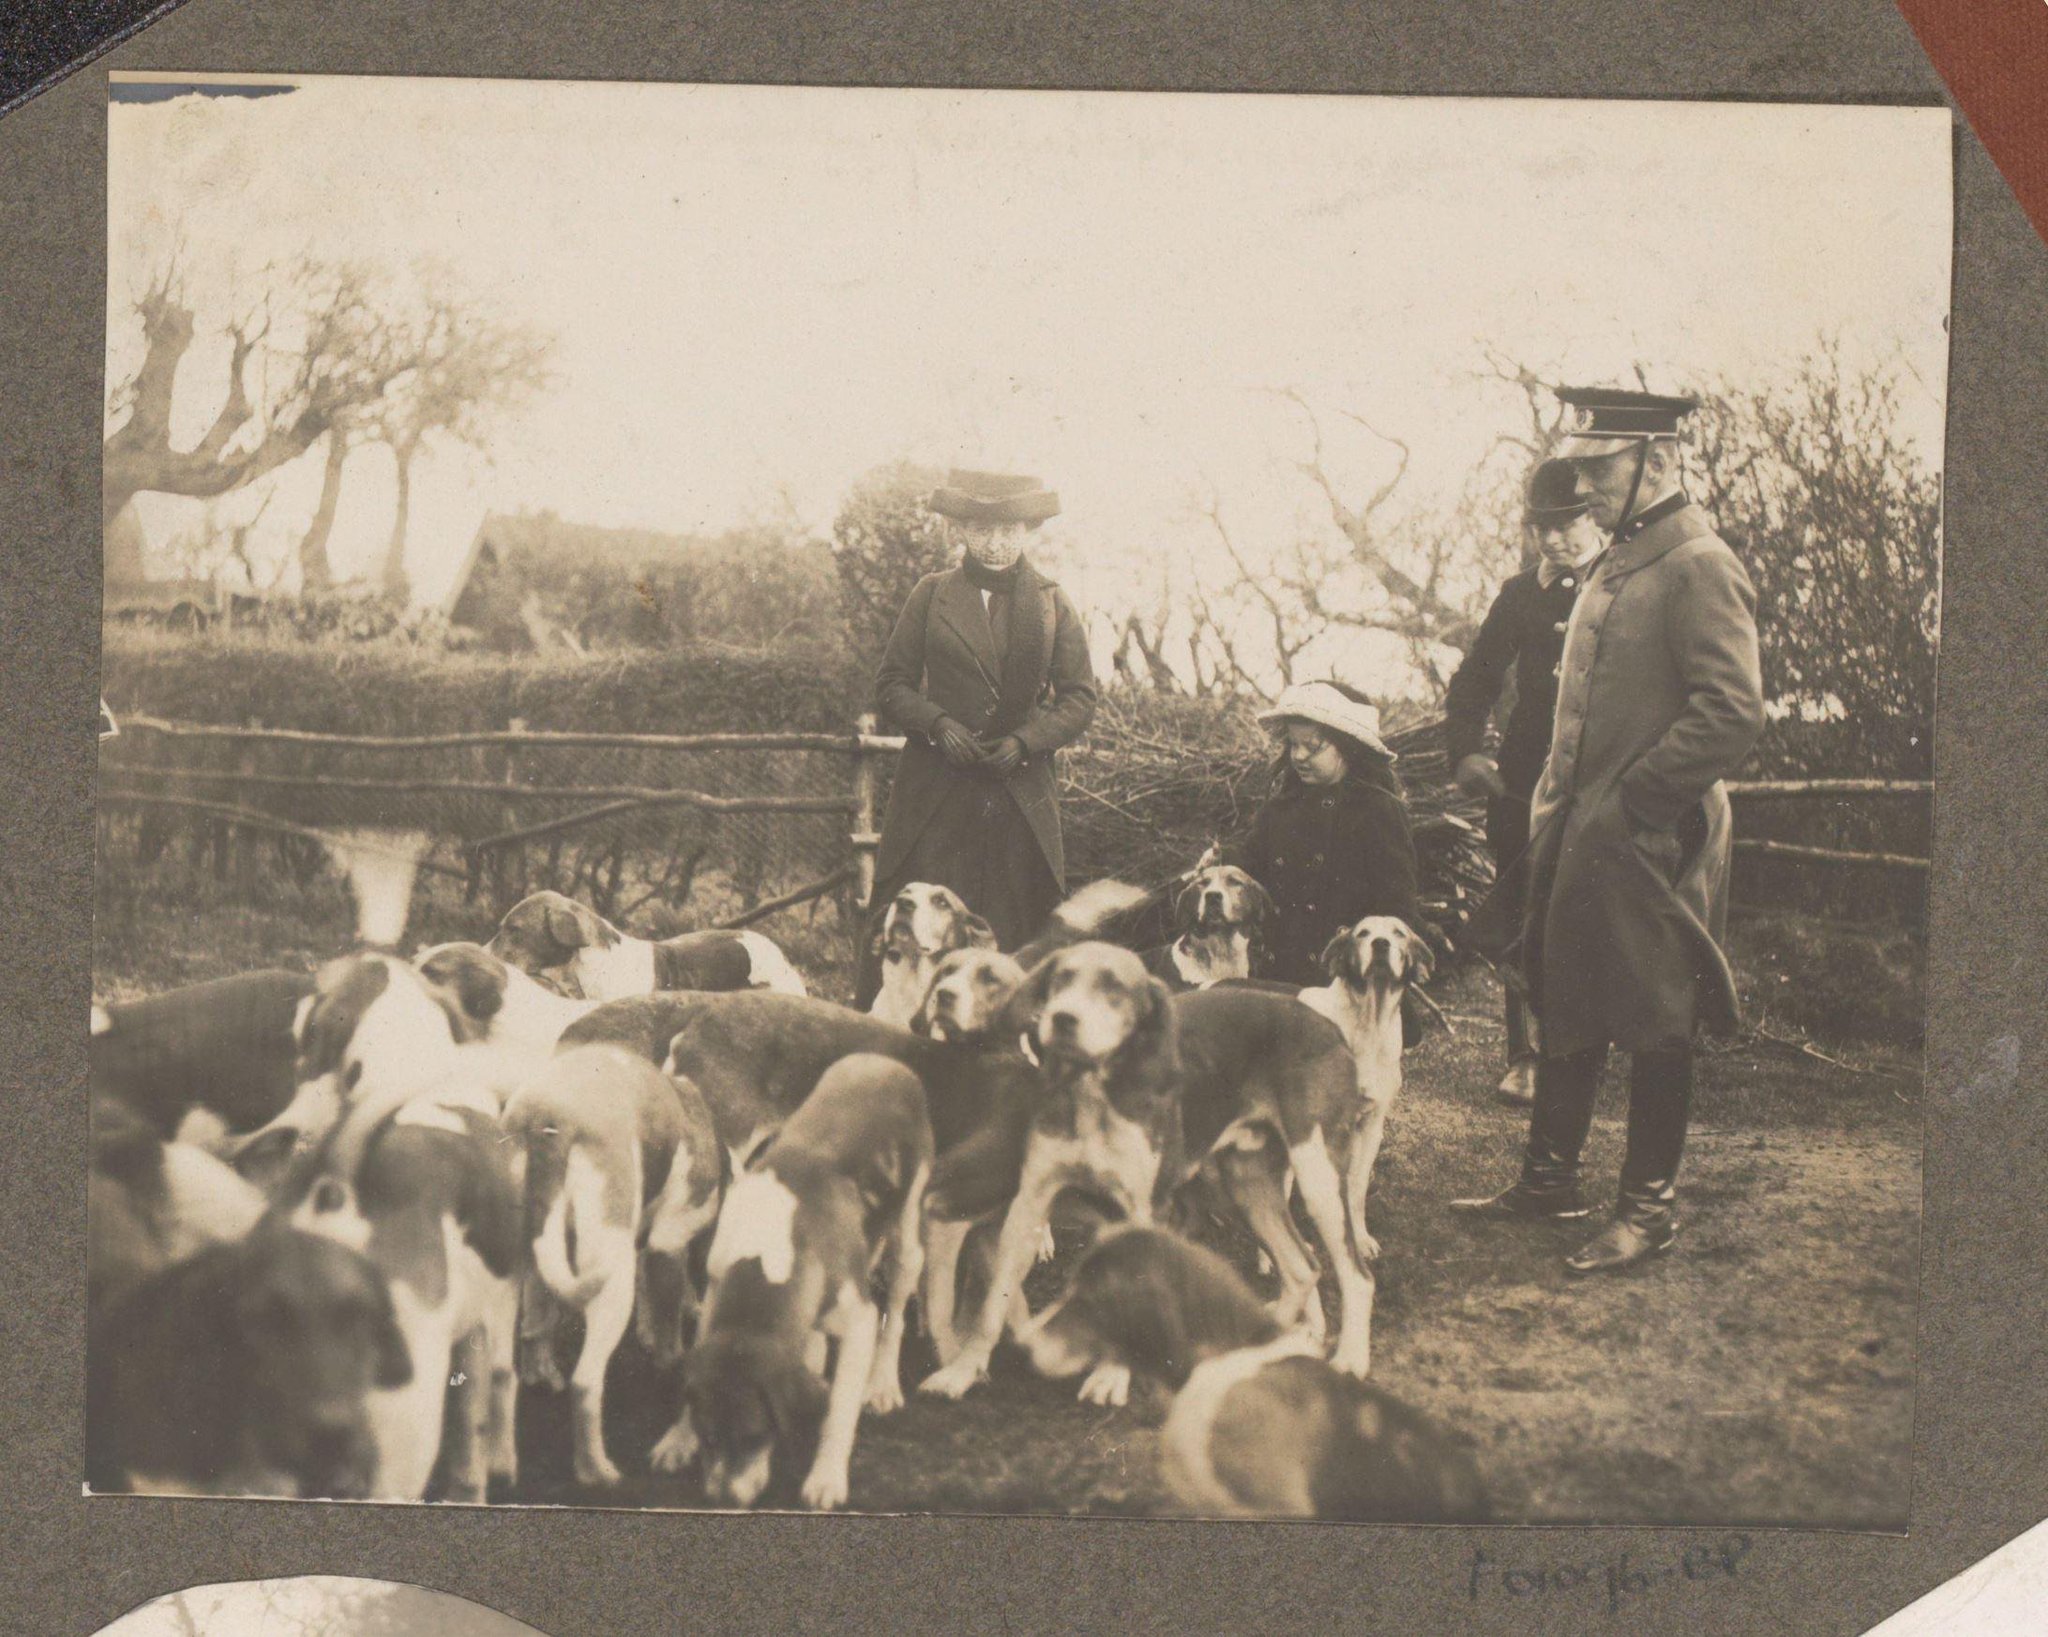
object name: photograph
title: Ruitertafereel op Koninklijke Houtvesterij Het Loo: gezelschap waaronder vrouw met kind bij meute honden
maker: Anonymous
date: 1900-1925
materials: photographic support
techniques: gelatin silver print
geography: het loo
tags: riding a horse, ass, or mule; rider, horseman, hunting, chase, hunting dogs, hunting-ground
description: Onderdeel van Fotoalbum van de heer Brams, opperhoutvester van koningin Wilhelmina op Koninklijke Houtvesterij Het Loo.